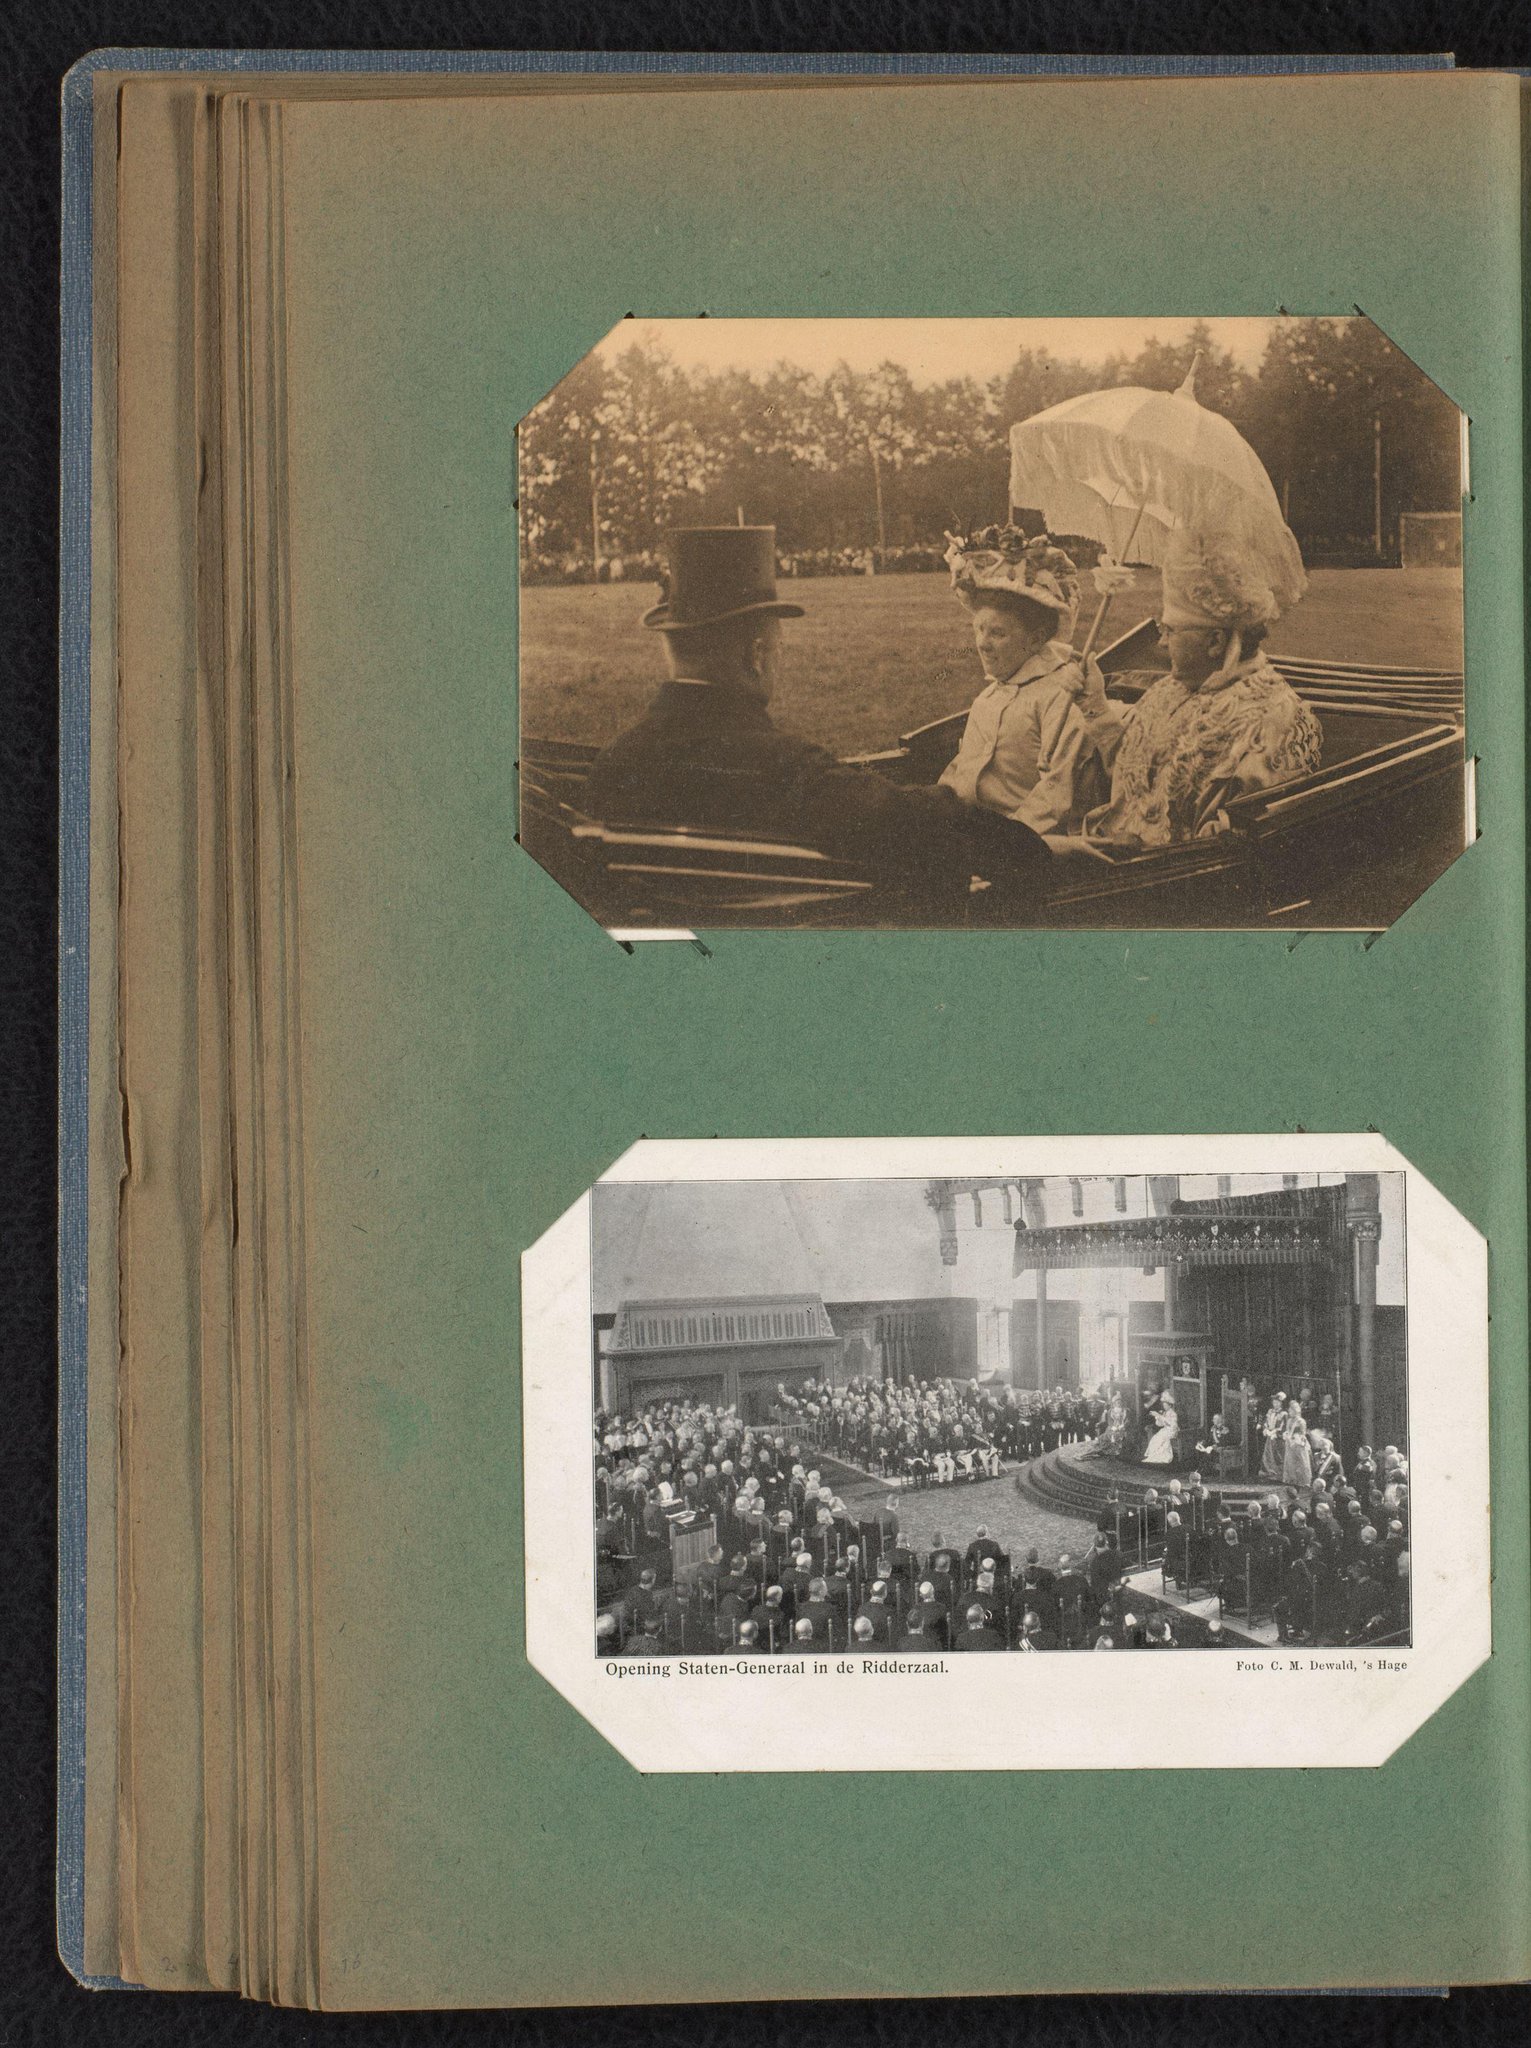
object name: photomechanical print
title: Twee prentbriefkaarten van de koninklijke familie in een koets en de opening van de Staten-Generaal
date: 1901-1920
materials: cardboard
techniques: photograph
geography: nijmegen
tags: the hague, print maker, wilhelmina of the netherlands, hendrik (prins der nederlanden (1876-1934)), emma (queen consort of the netherlands), four-wheeled, animal-drawn vehicle, e.g.: cab, carriage, coach, queen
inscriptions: inscription: ‘Opening Staten-Generaal in de Ridderzaal.’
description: Deze prenten maken deel uit van een album.